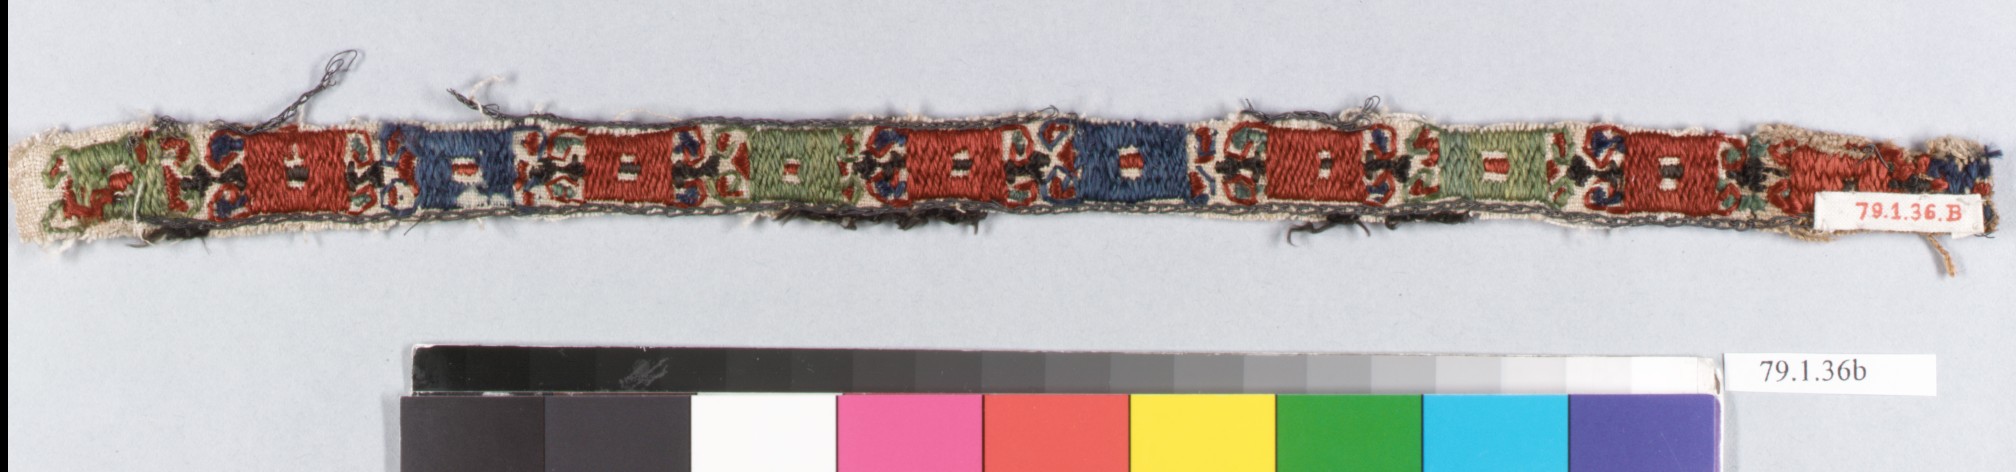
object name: fragment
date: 1801-1833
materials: linen, metal thread, silk